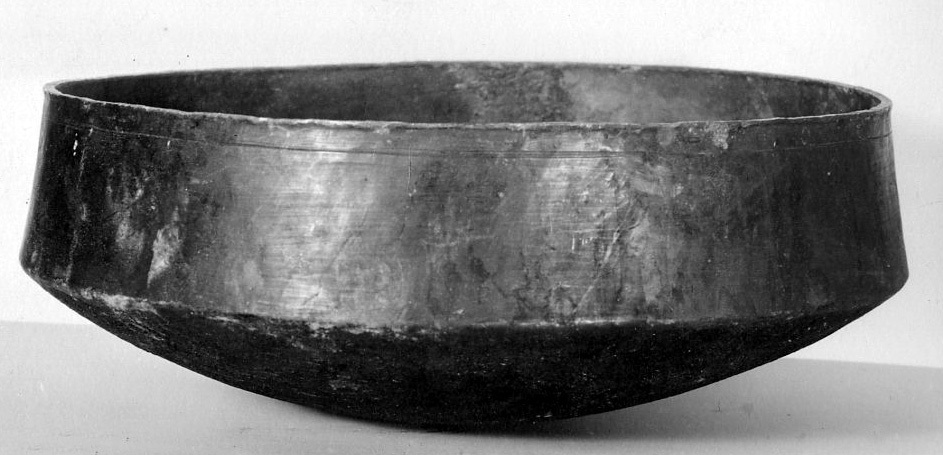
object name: bowl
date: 306-30 BCE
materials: bronze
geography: egypt